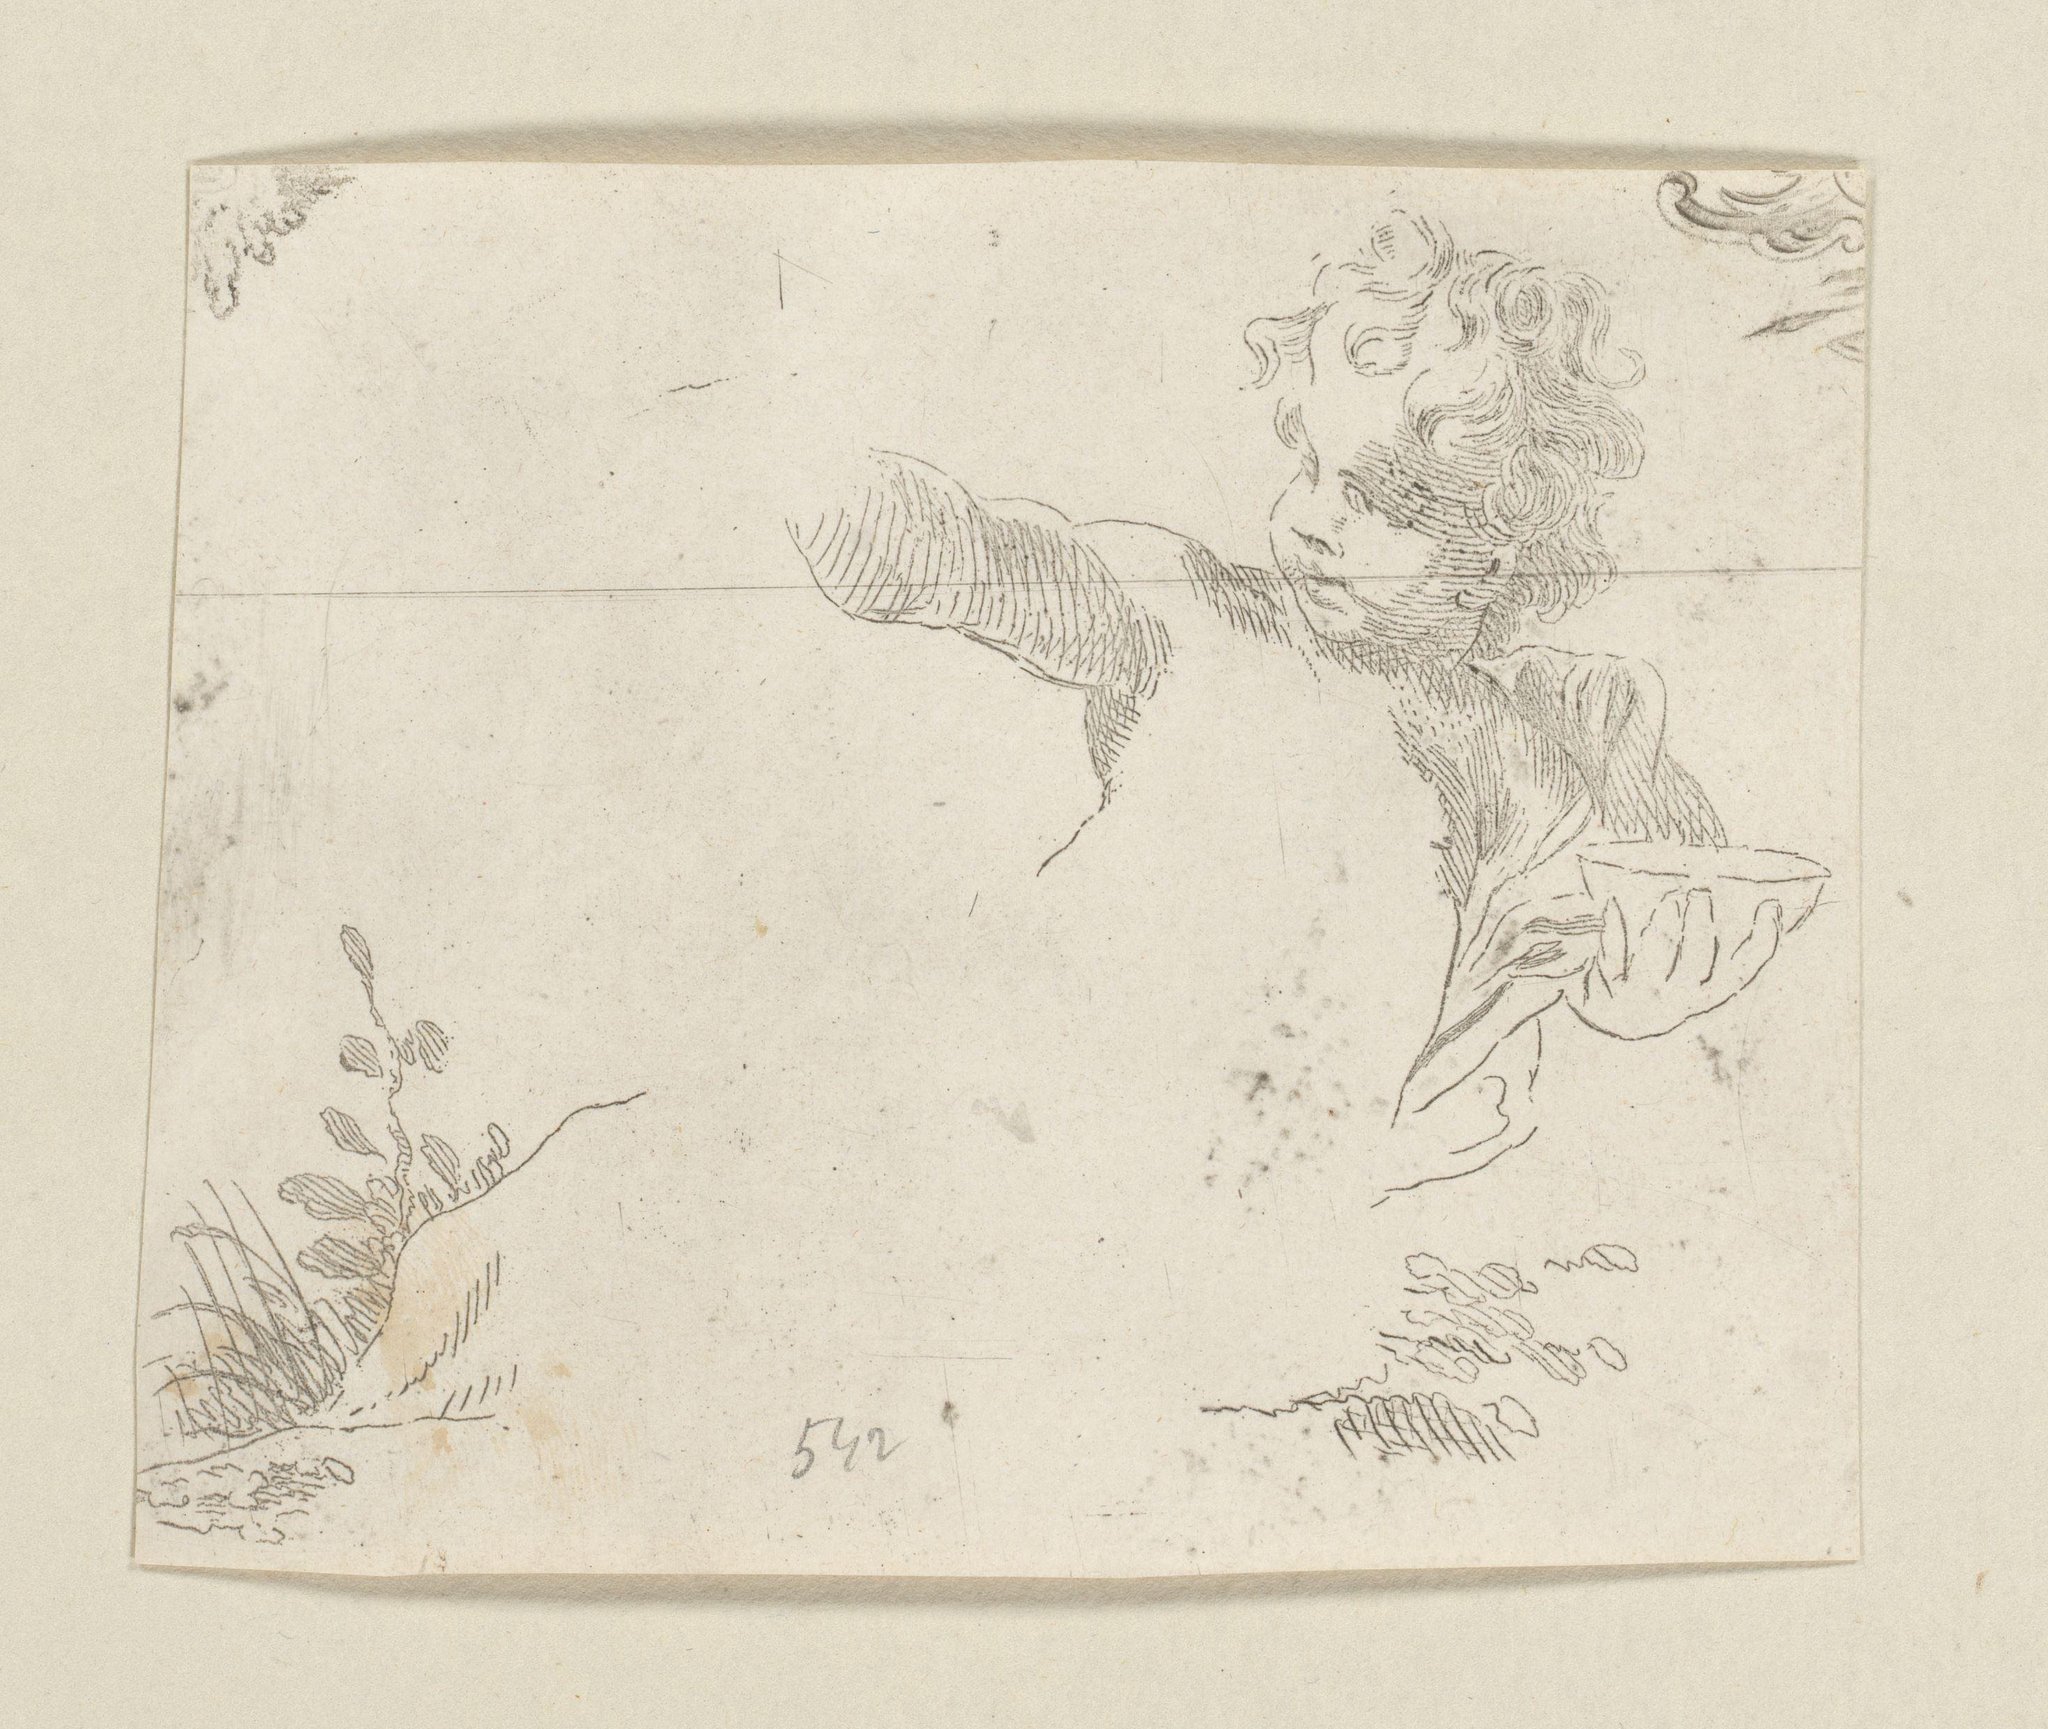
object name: print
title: Engel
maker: cornelis ploos van amstel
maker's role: draughtsman, print maker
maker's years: 1726-1798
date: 1736-1798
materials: paper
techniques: etching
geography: amsterdam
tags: angels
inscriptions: collector's mark: ‘RIJKS / MUSM’, collector's mark: Lugt 2725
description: Engel met in de hoek van de afdruk een gedeelte van het wapen dat Ploos van Amstel later als merk op de achterzijde van zijn prenten drukte. De prent ligt los achterin een album.